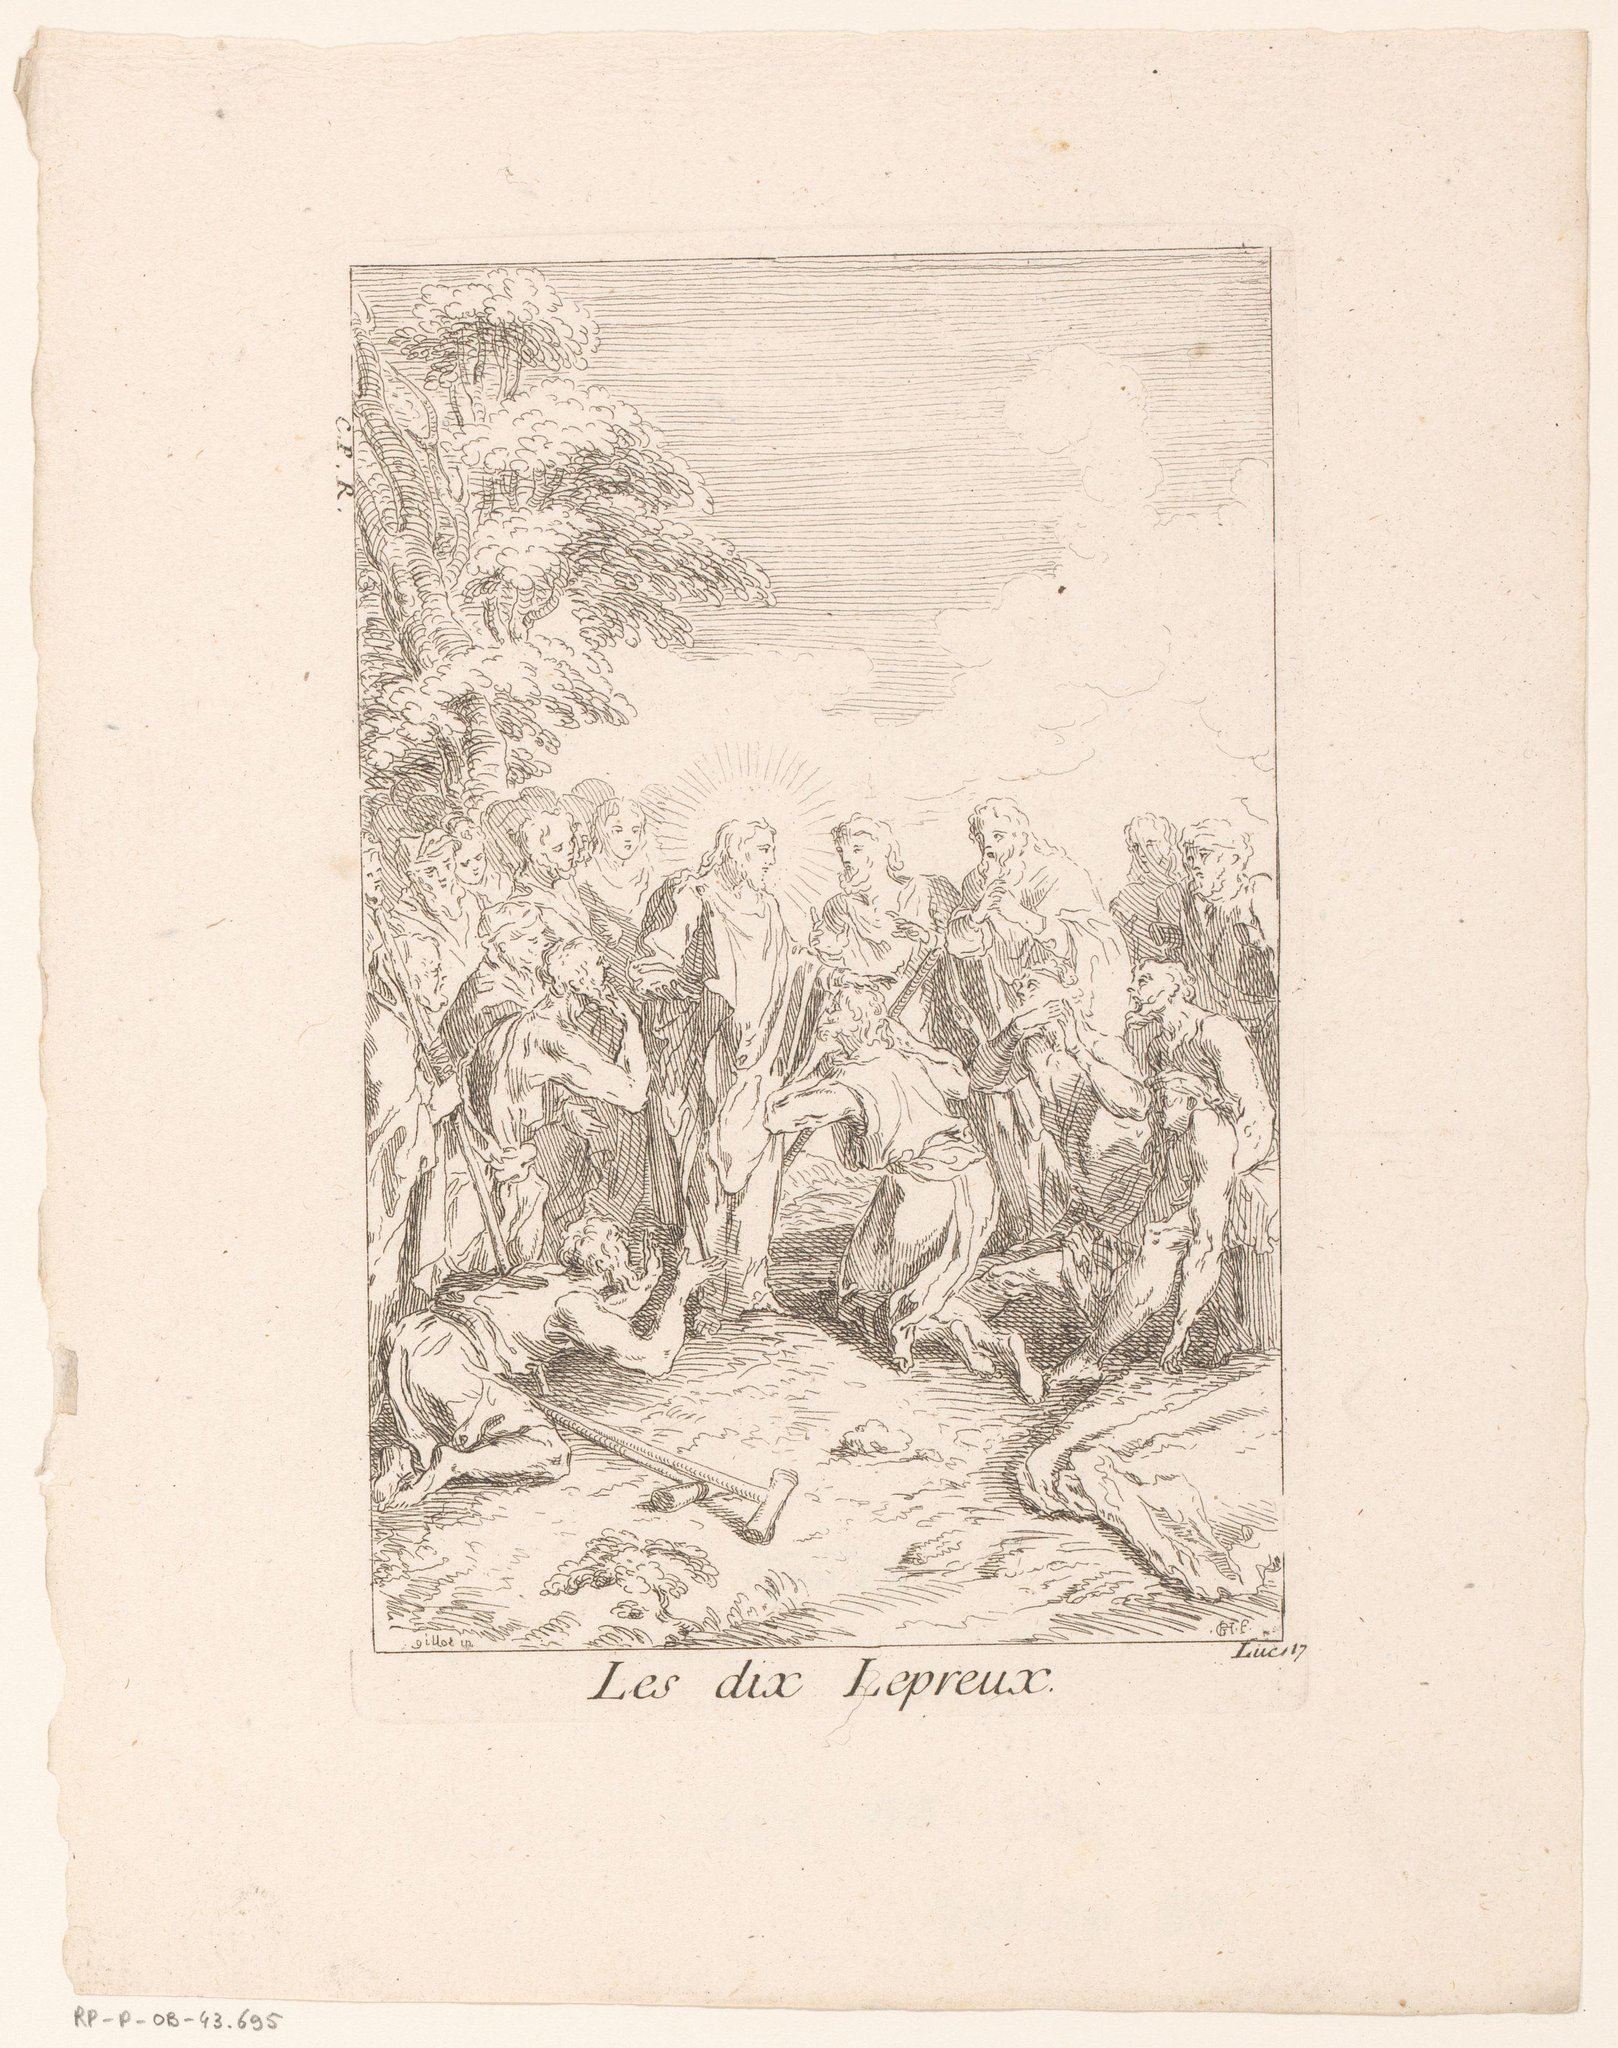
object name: print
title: Leven en passie van Christus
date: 1705-1732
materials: paper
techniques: etching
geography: paris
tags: christ sends ten lepers to the priest (luke 17:11-19)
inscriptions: collector's mark: Lugt 2228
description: Maakt deel uit van een serie met zestig prenten met als thema het leven van Christus.